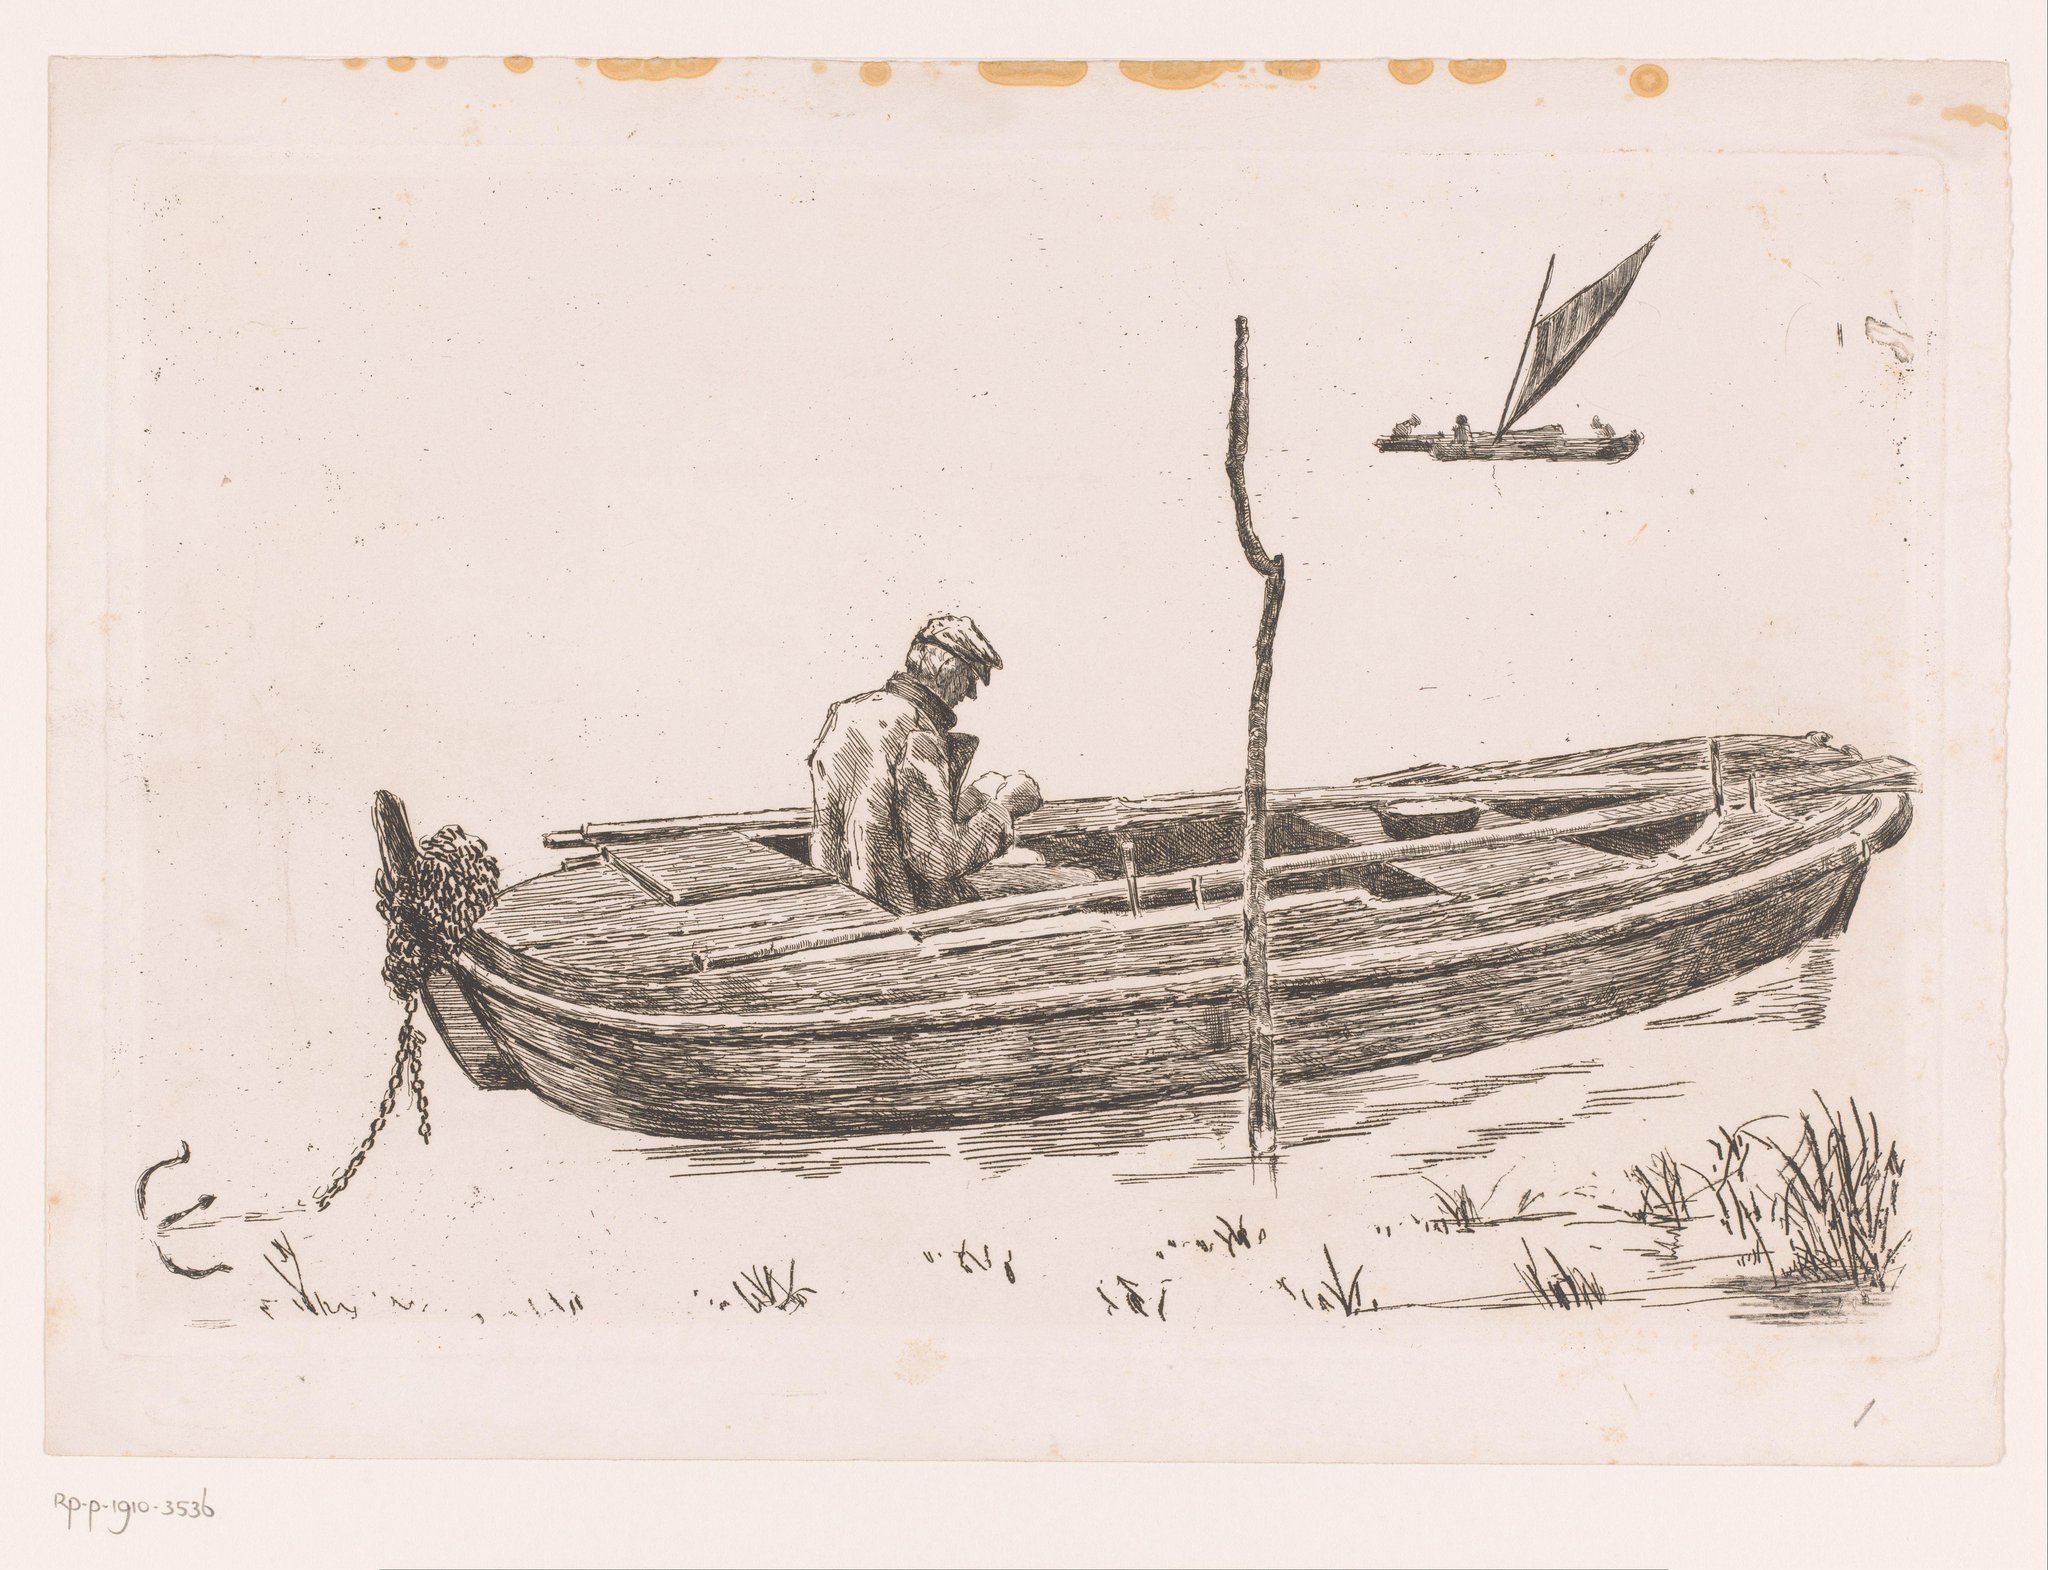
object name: print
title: Roeiboot voor anker in open water en een zeilboot op de achtergrond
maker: jules guiette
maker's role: print maker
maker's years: 1852-1901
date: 1862-1901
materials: paper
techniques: drypoint, etching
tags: rowing-boat, canoe, etc., parts of ship's exterior: anchor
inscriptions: annotation: ‘I’, collector's mark: Lugt 2228